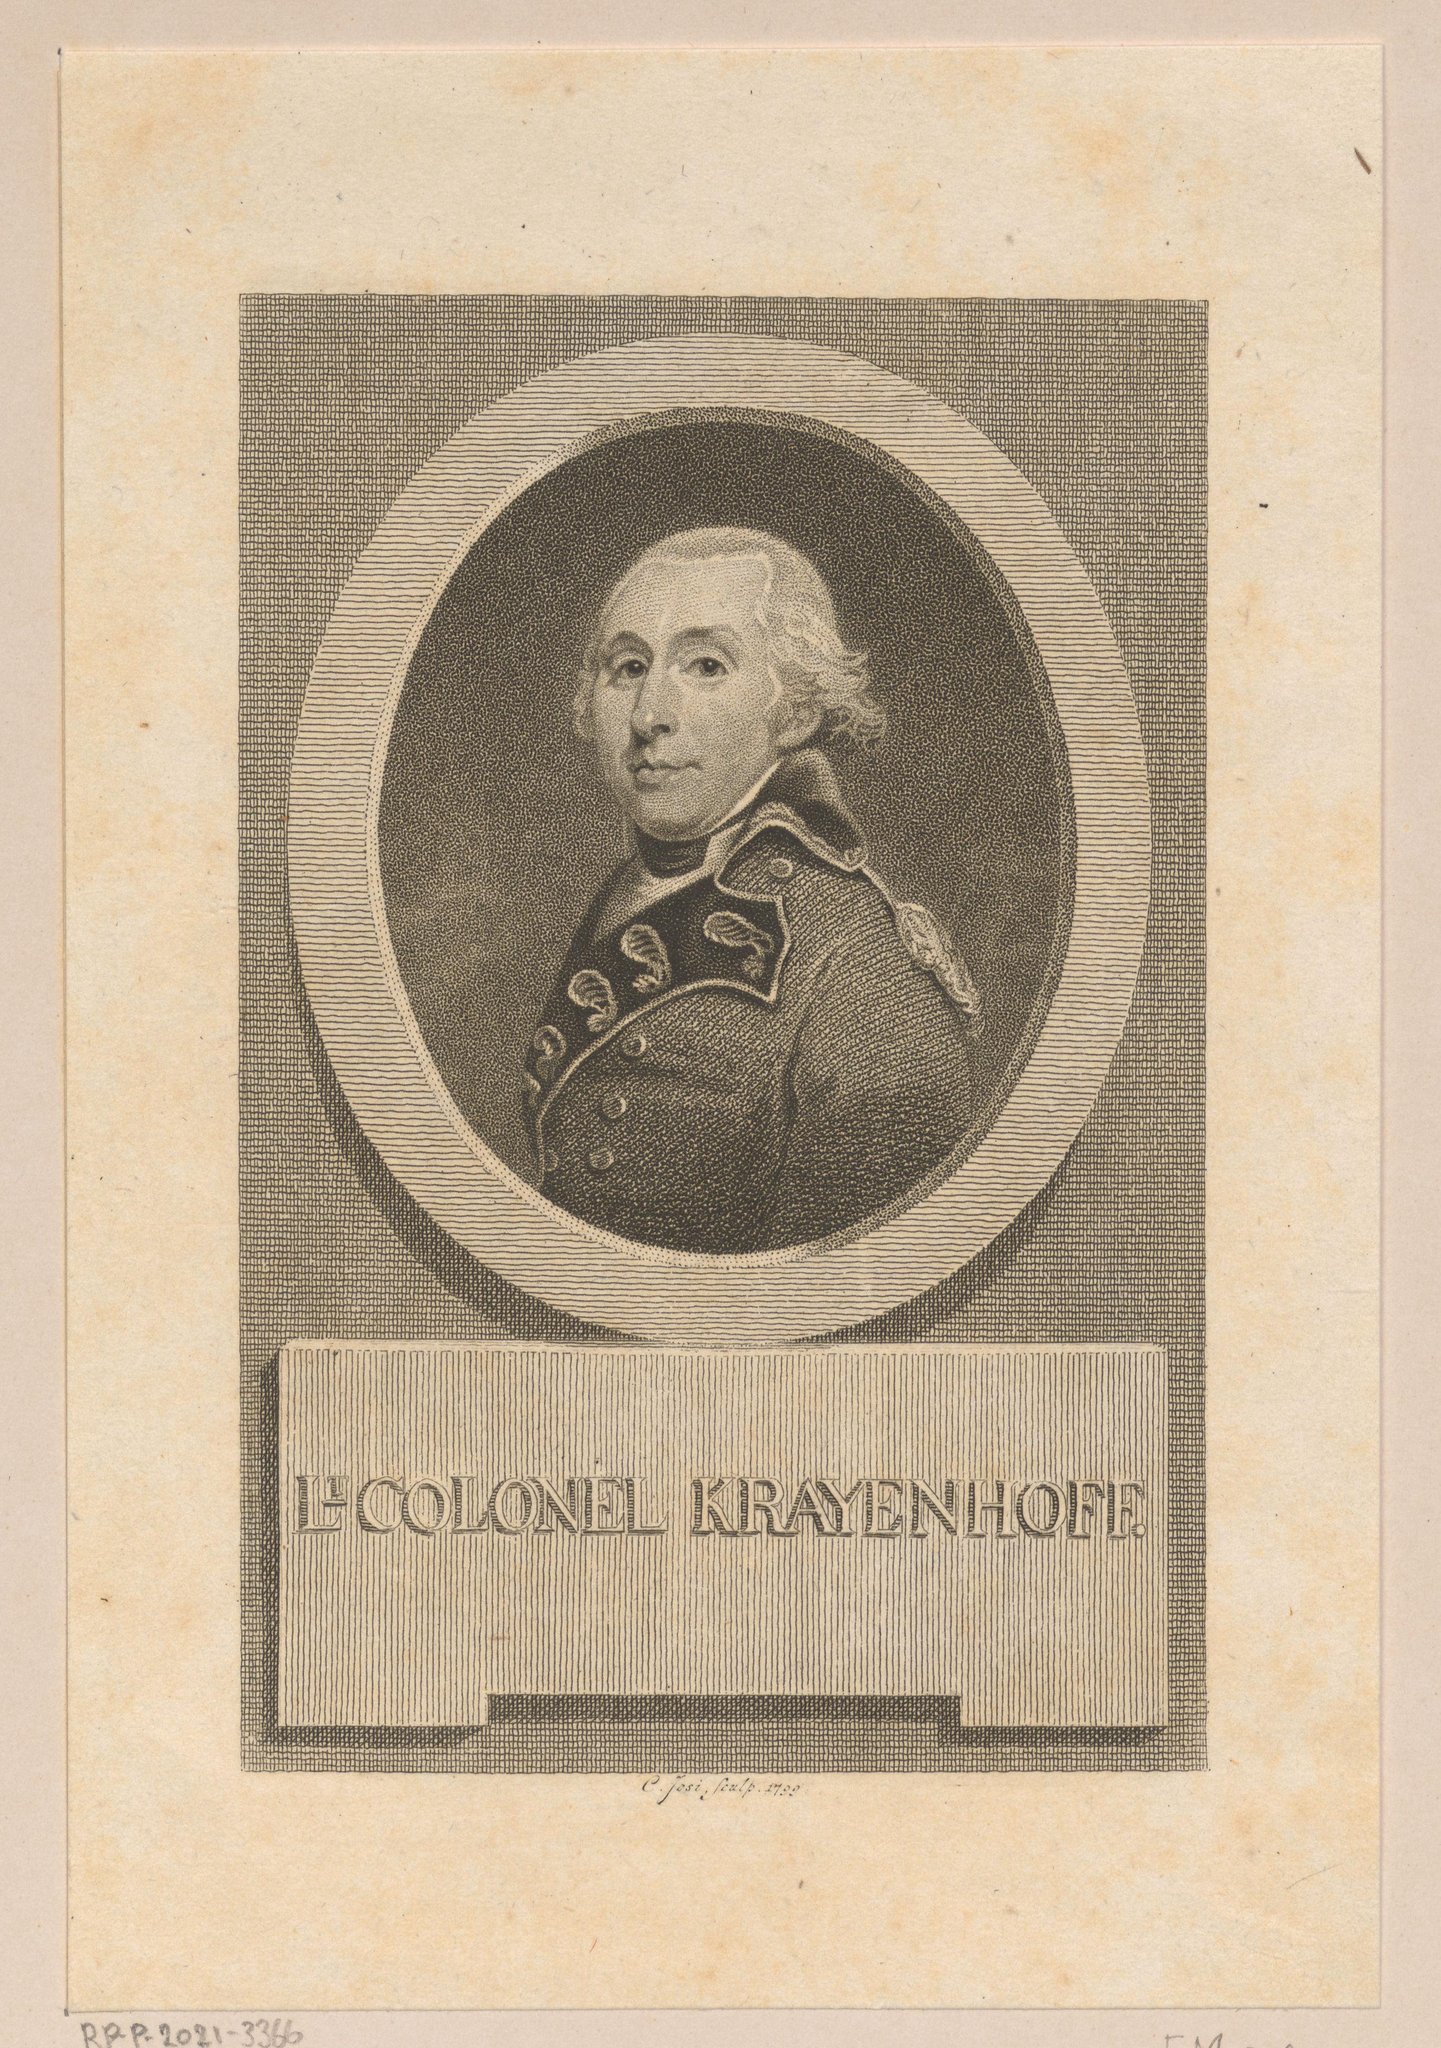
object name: print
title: Portret van Cornelis Rudolphus Theodorus Krayenhoff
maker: christiaan josi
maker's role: draughtsman, print maker, publisher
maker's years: 1765-1828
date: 1799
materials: paper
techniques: etching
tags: nijmegen, cornelis rudolphus theodorus krayenhoff, historical persons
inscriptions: date